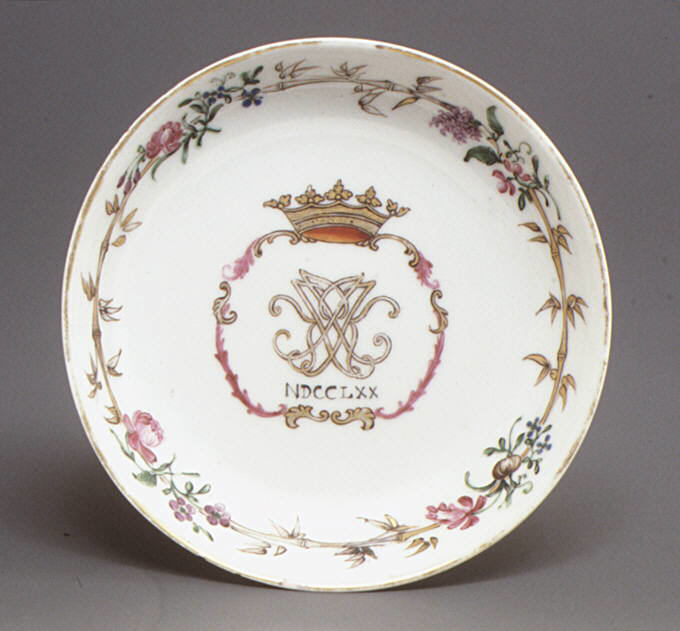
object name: saucer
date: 1770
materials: hard paste porcelain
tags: flowers,insignia